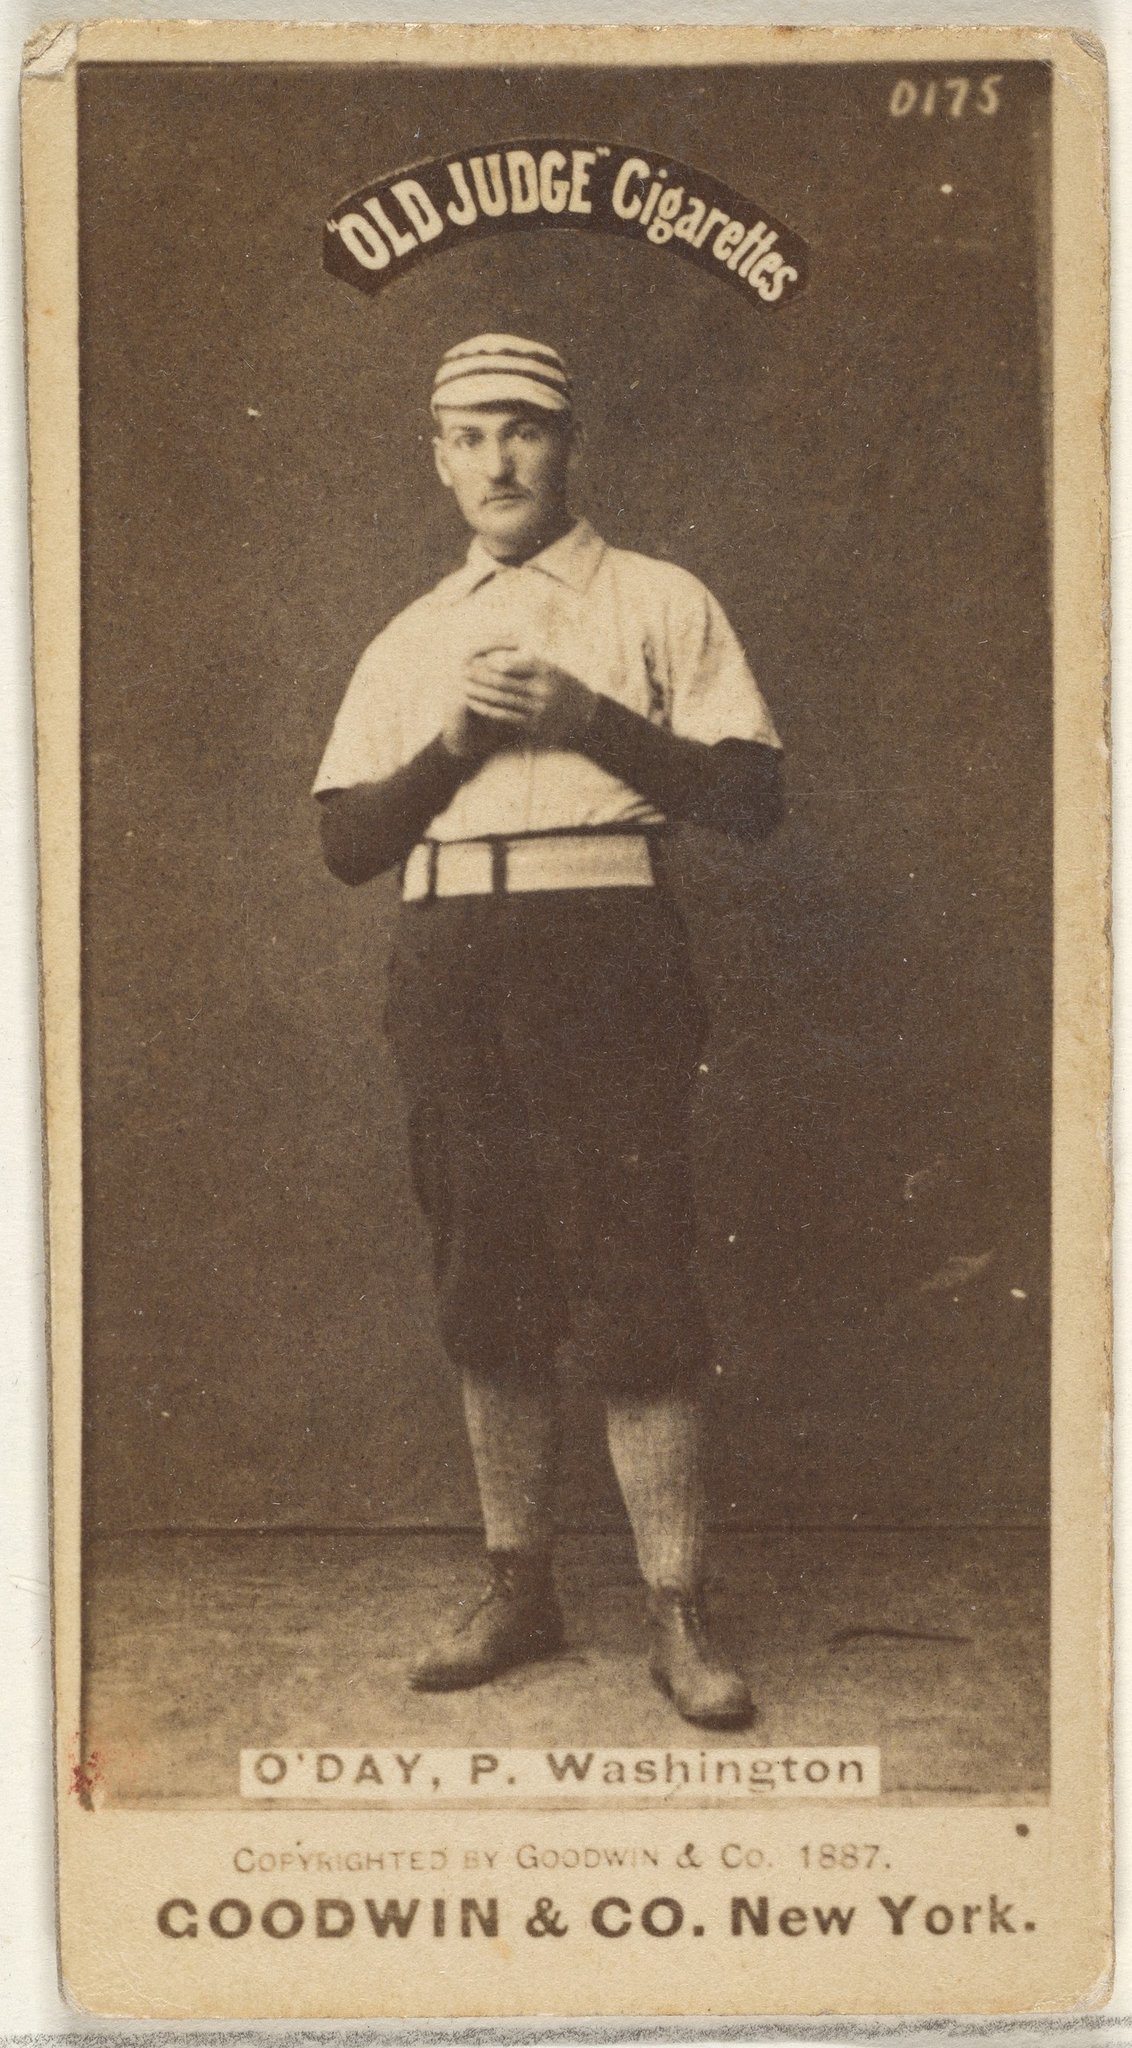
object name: baseball card, photograph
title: Henry Francis "Hank" O'Day, Pitcher, Washington Nationals, from the Old Judge series (N172) for Old Judge Cigarettes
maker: goodwin & company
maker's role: publisher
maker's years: 1850-1950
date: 1887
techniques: albumen silver print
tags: men,portraits,baseball,athletes